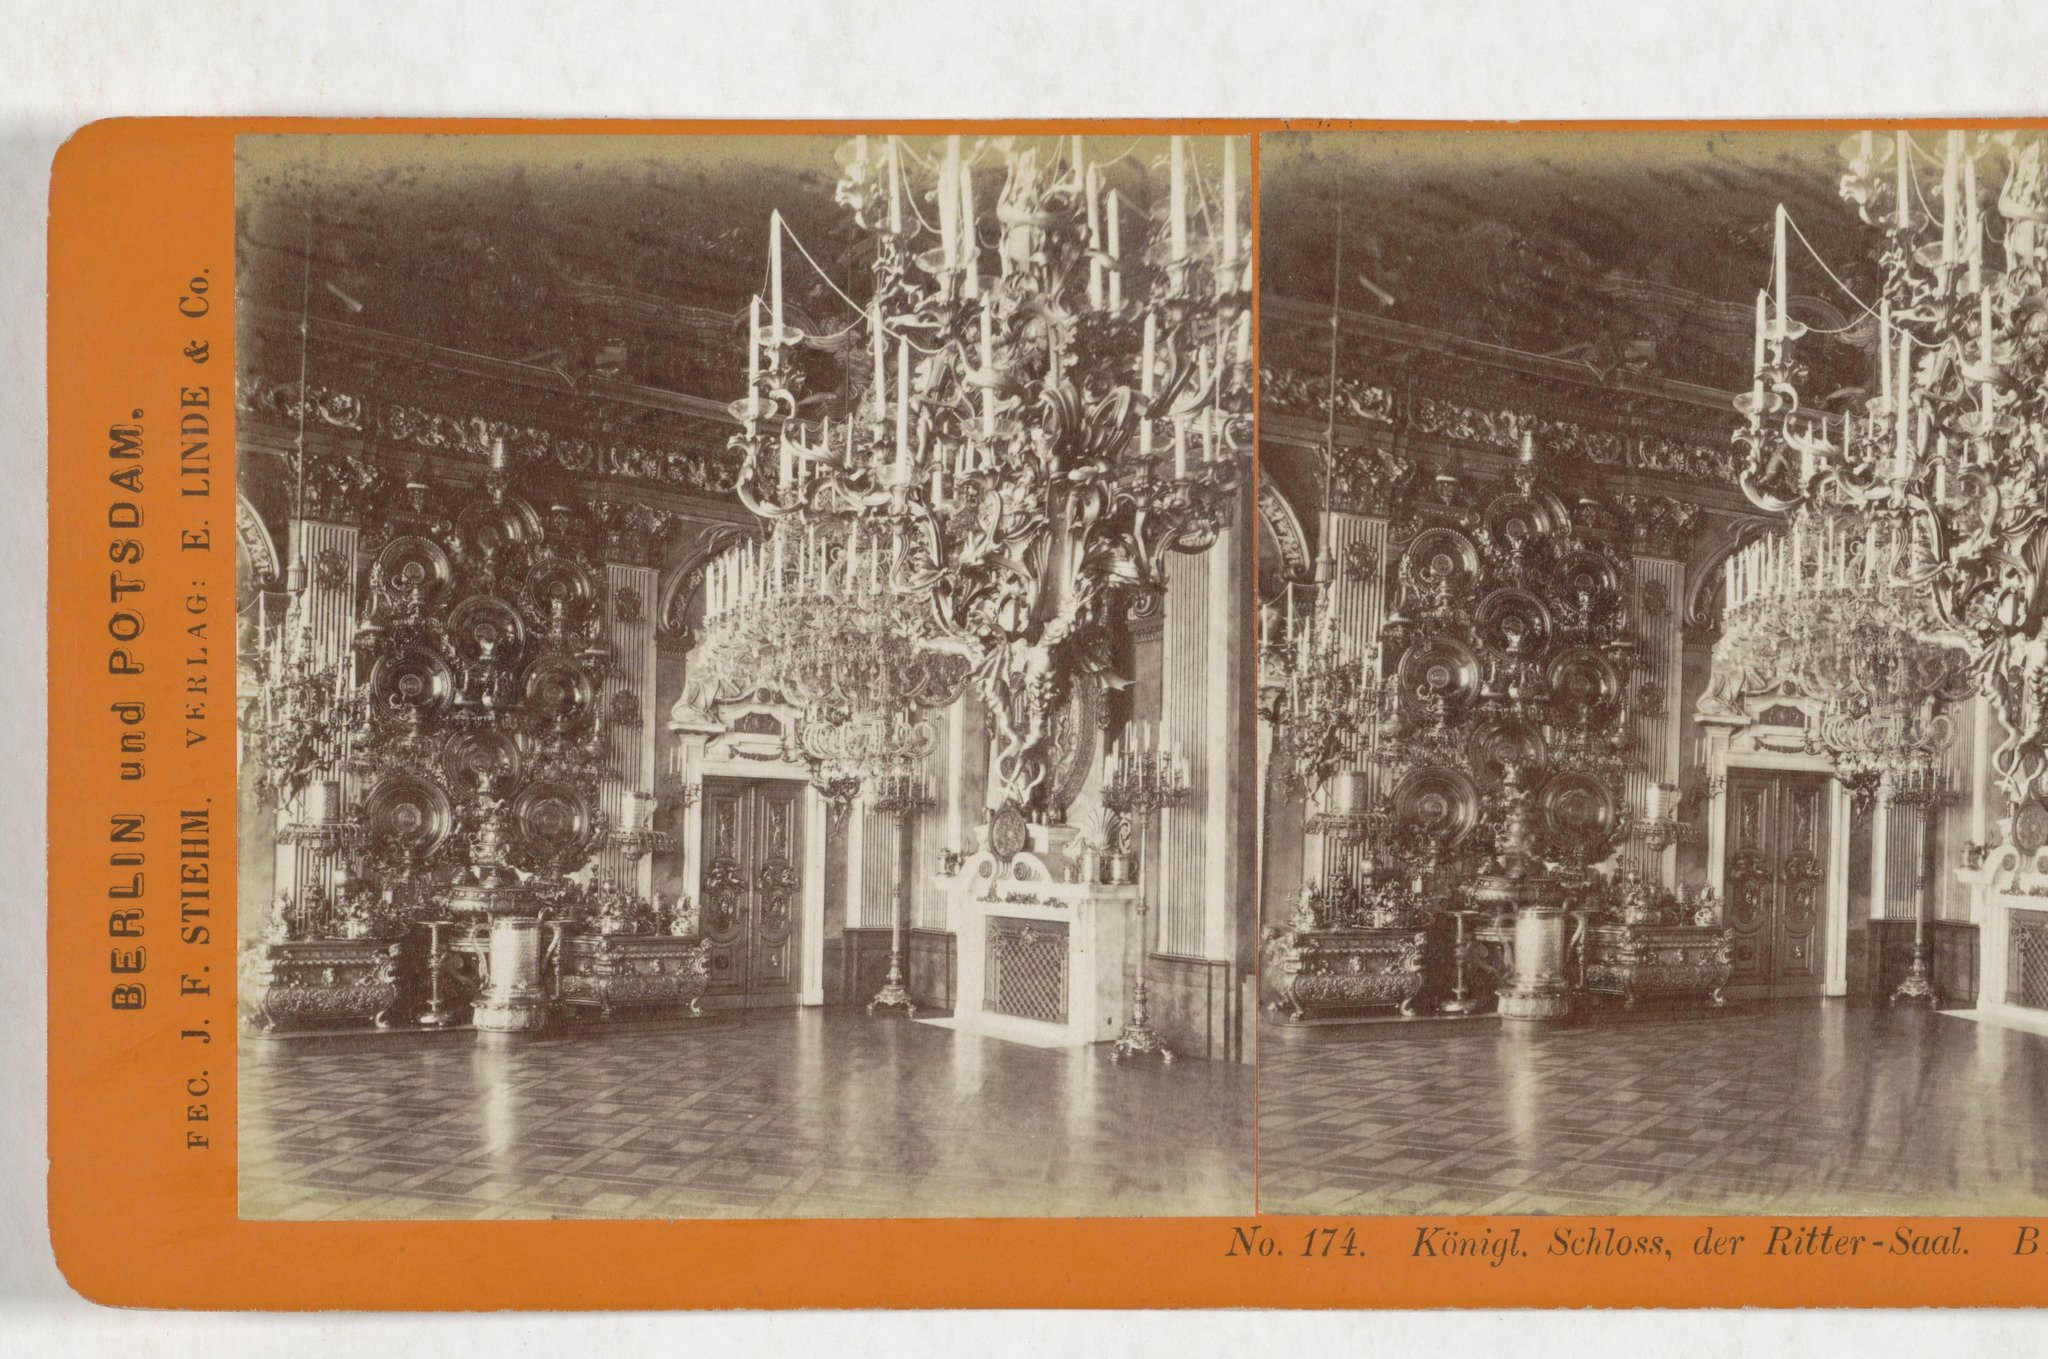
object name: stereograph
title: Königl. Schloss, der Ritter-Saal. Berlin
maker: johann friedrich stiehm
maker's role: fotograaf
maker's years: 1826-1902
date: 1868-1870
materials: cardboard, paper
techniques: albumen print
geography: berlin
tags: throne-room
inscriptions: number: ‘No. 174.’